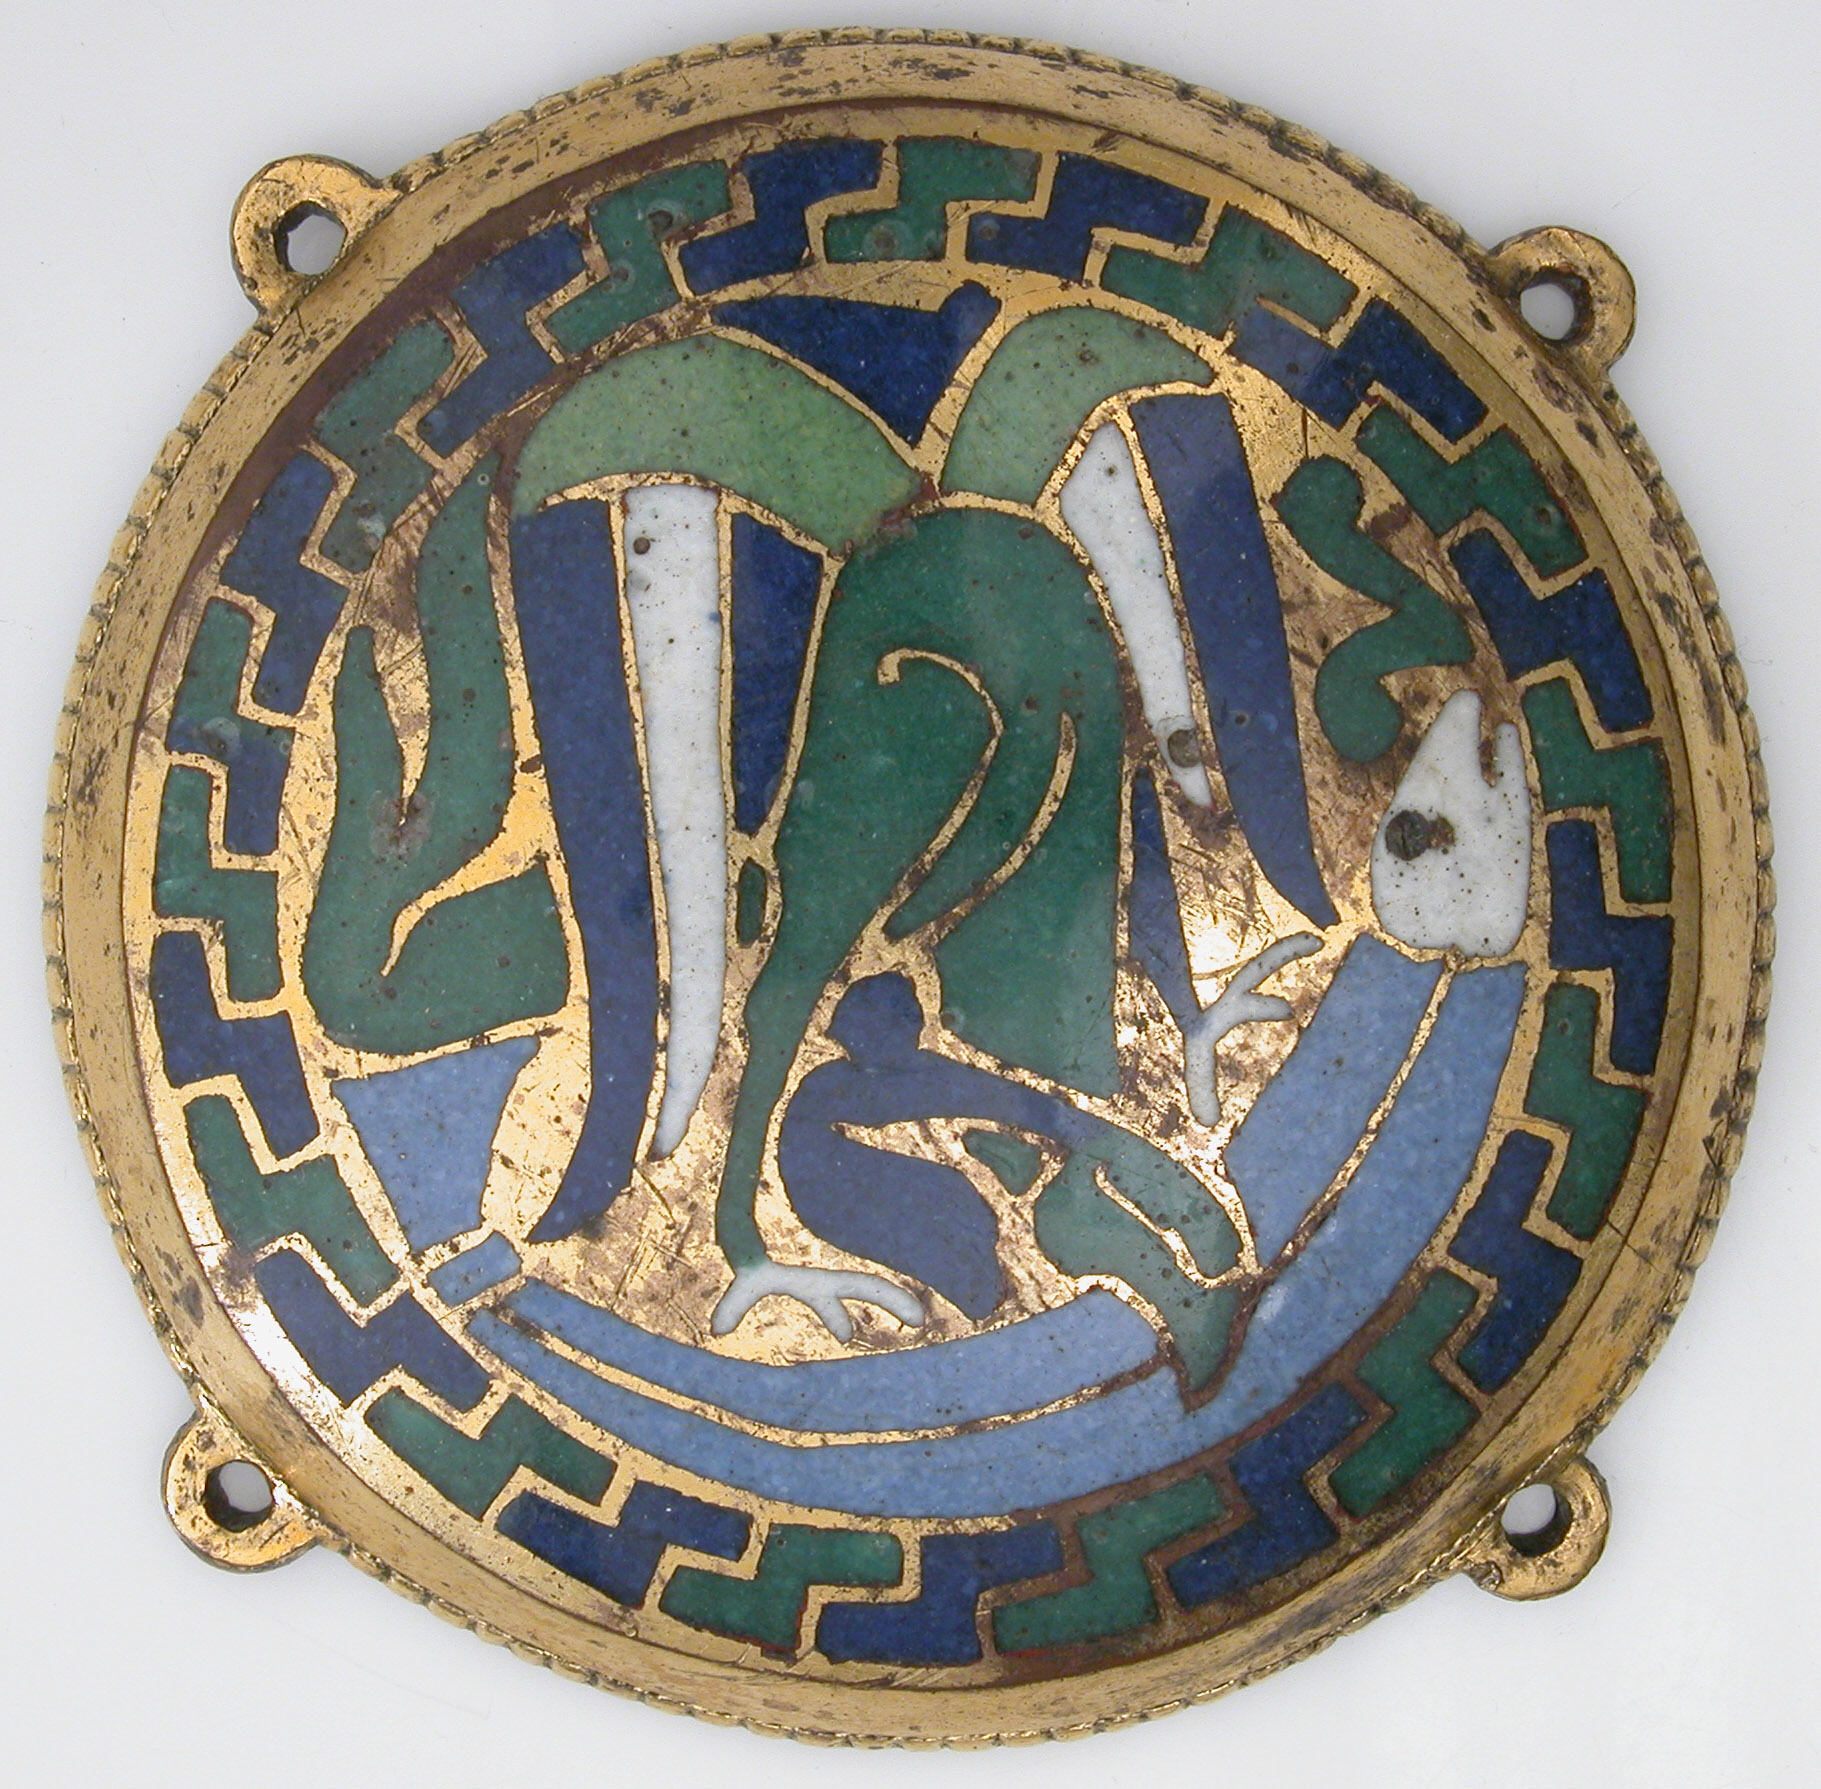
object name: medallion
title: Eagle Attacking a Fish (one of five medallions from a coffret)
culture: french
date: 1110-1130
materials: gilt copper, enamel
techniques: enamel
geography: france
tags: eagles,fish